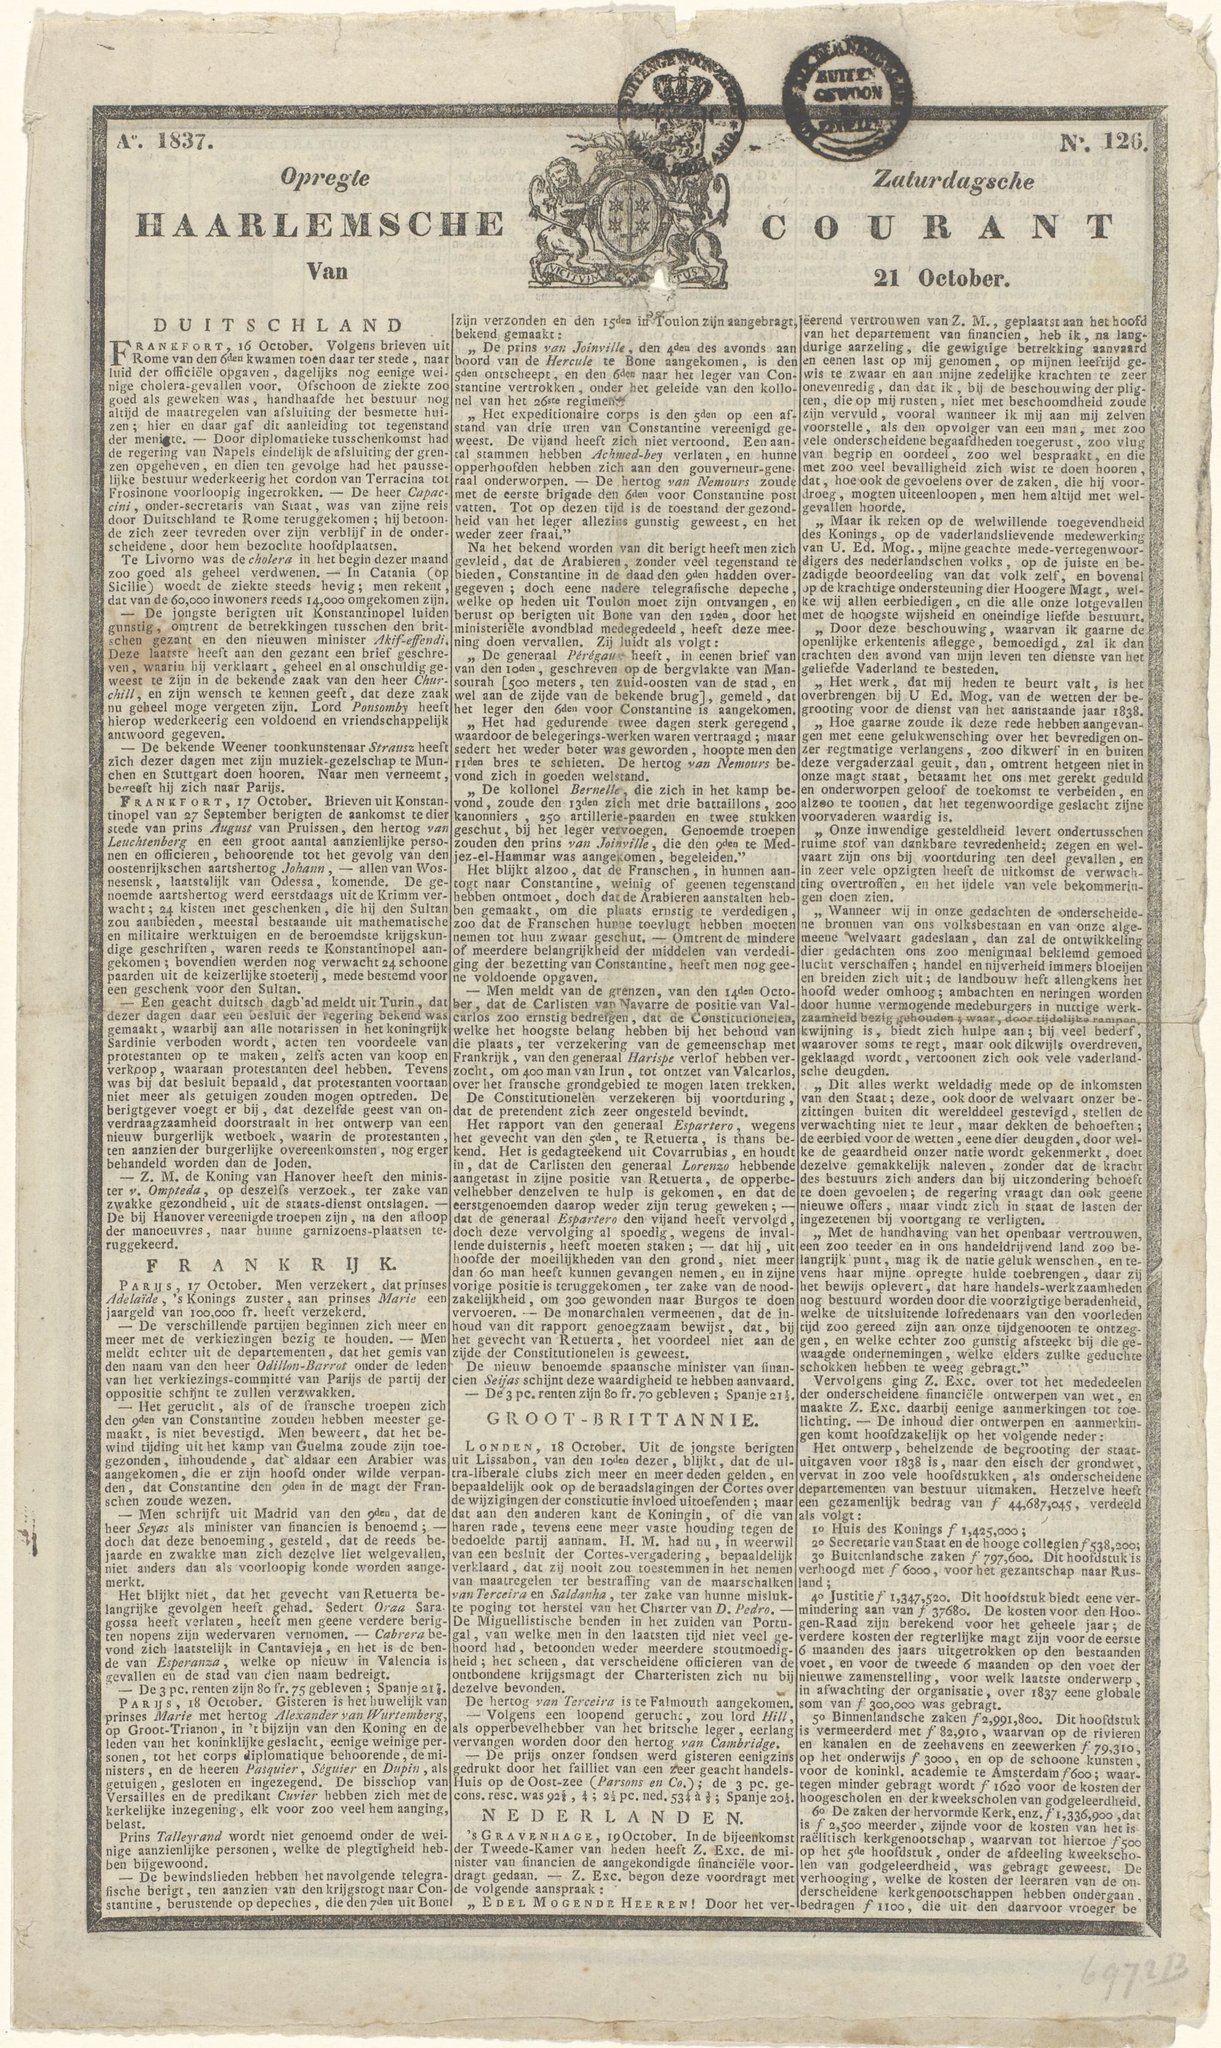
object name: newspaper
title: Opregte Zaturdagsche Haarlemsche Courant van 21 Oktober. Ao. 1837. No. 126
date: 1837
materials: paper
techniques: letterpress printing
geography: haarlem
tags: berlin, the hague, wilhelmina frederica louisa (koningin der nederlanden)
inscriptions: collector's mark: Lugt 2228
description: Exemplaar van de Opregte Haarlemsche Courant van 21 oktober 1837 met nieuws over de dood van koningin Wilhelmina van Pruisen op 12 oktober 1837. Dubbelgevouwen blad bedrukt op alle zijden.